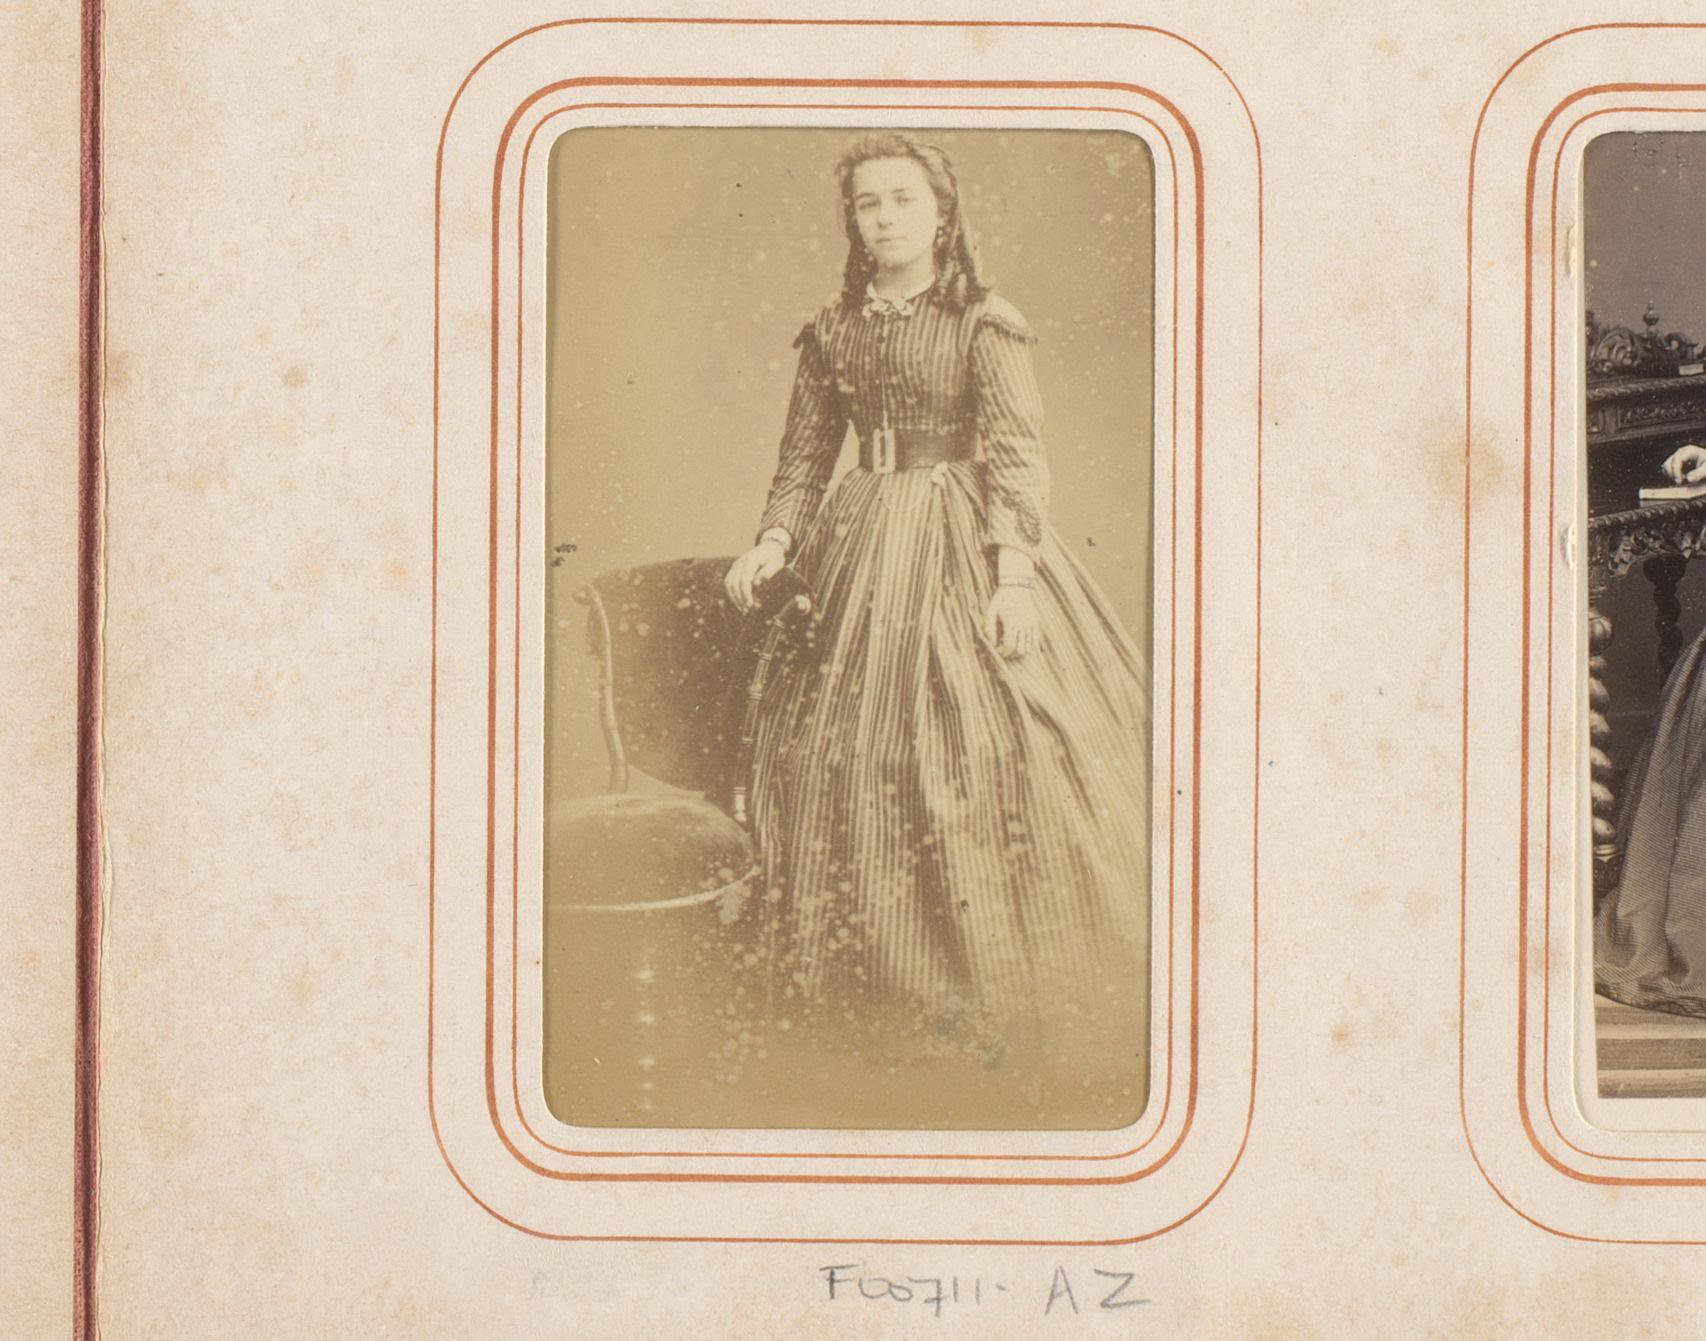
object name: photograph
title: Portret van een jonge vrouw bij een stoel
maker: e. cornelisse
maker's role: fotograaf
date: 1860-1870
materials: cardboard, photographic support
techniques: albumen print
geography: netherlands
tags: adolescent, young woman, maiden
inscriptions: inscription: ‘Cornelisse/ Rotterdam/ Tilburg/ English spoken (...)’